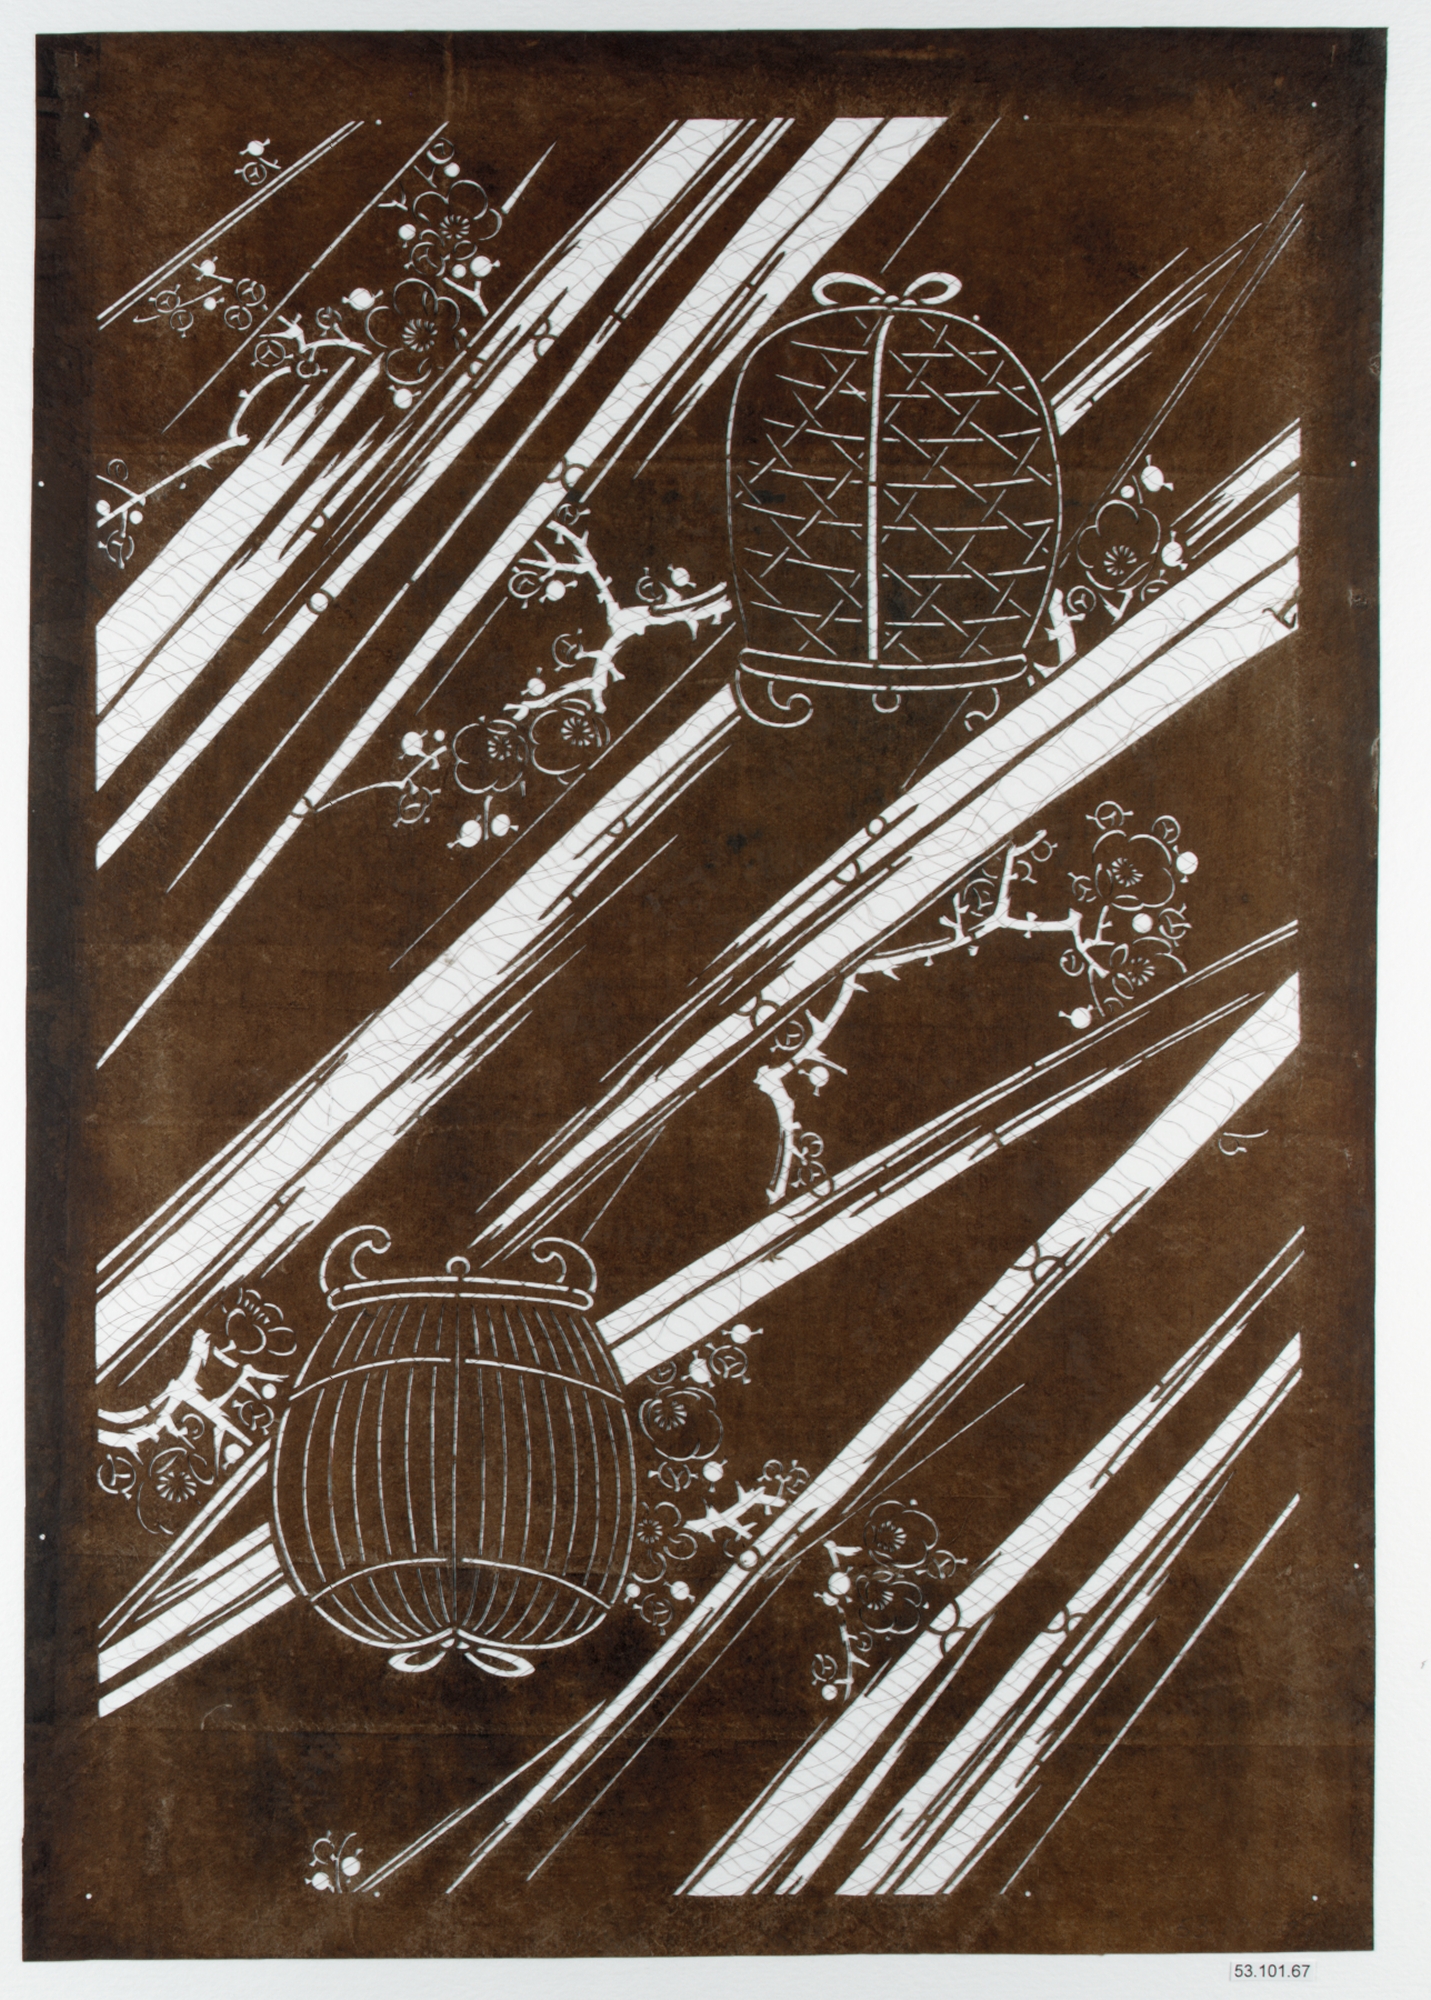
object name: stencil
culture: japanese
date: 1615-1868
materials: paper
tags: flowers